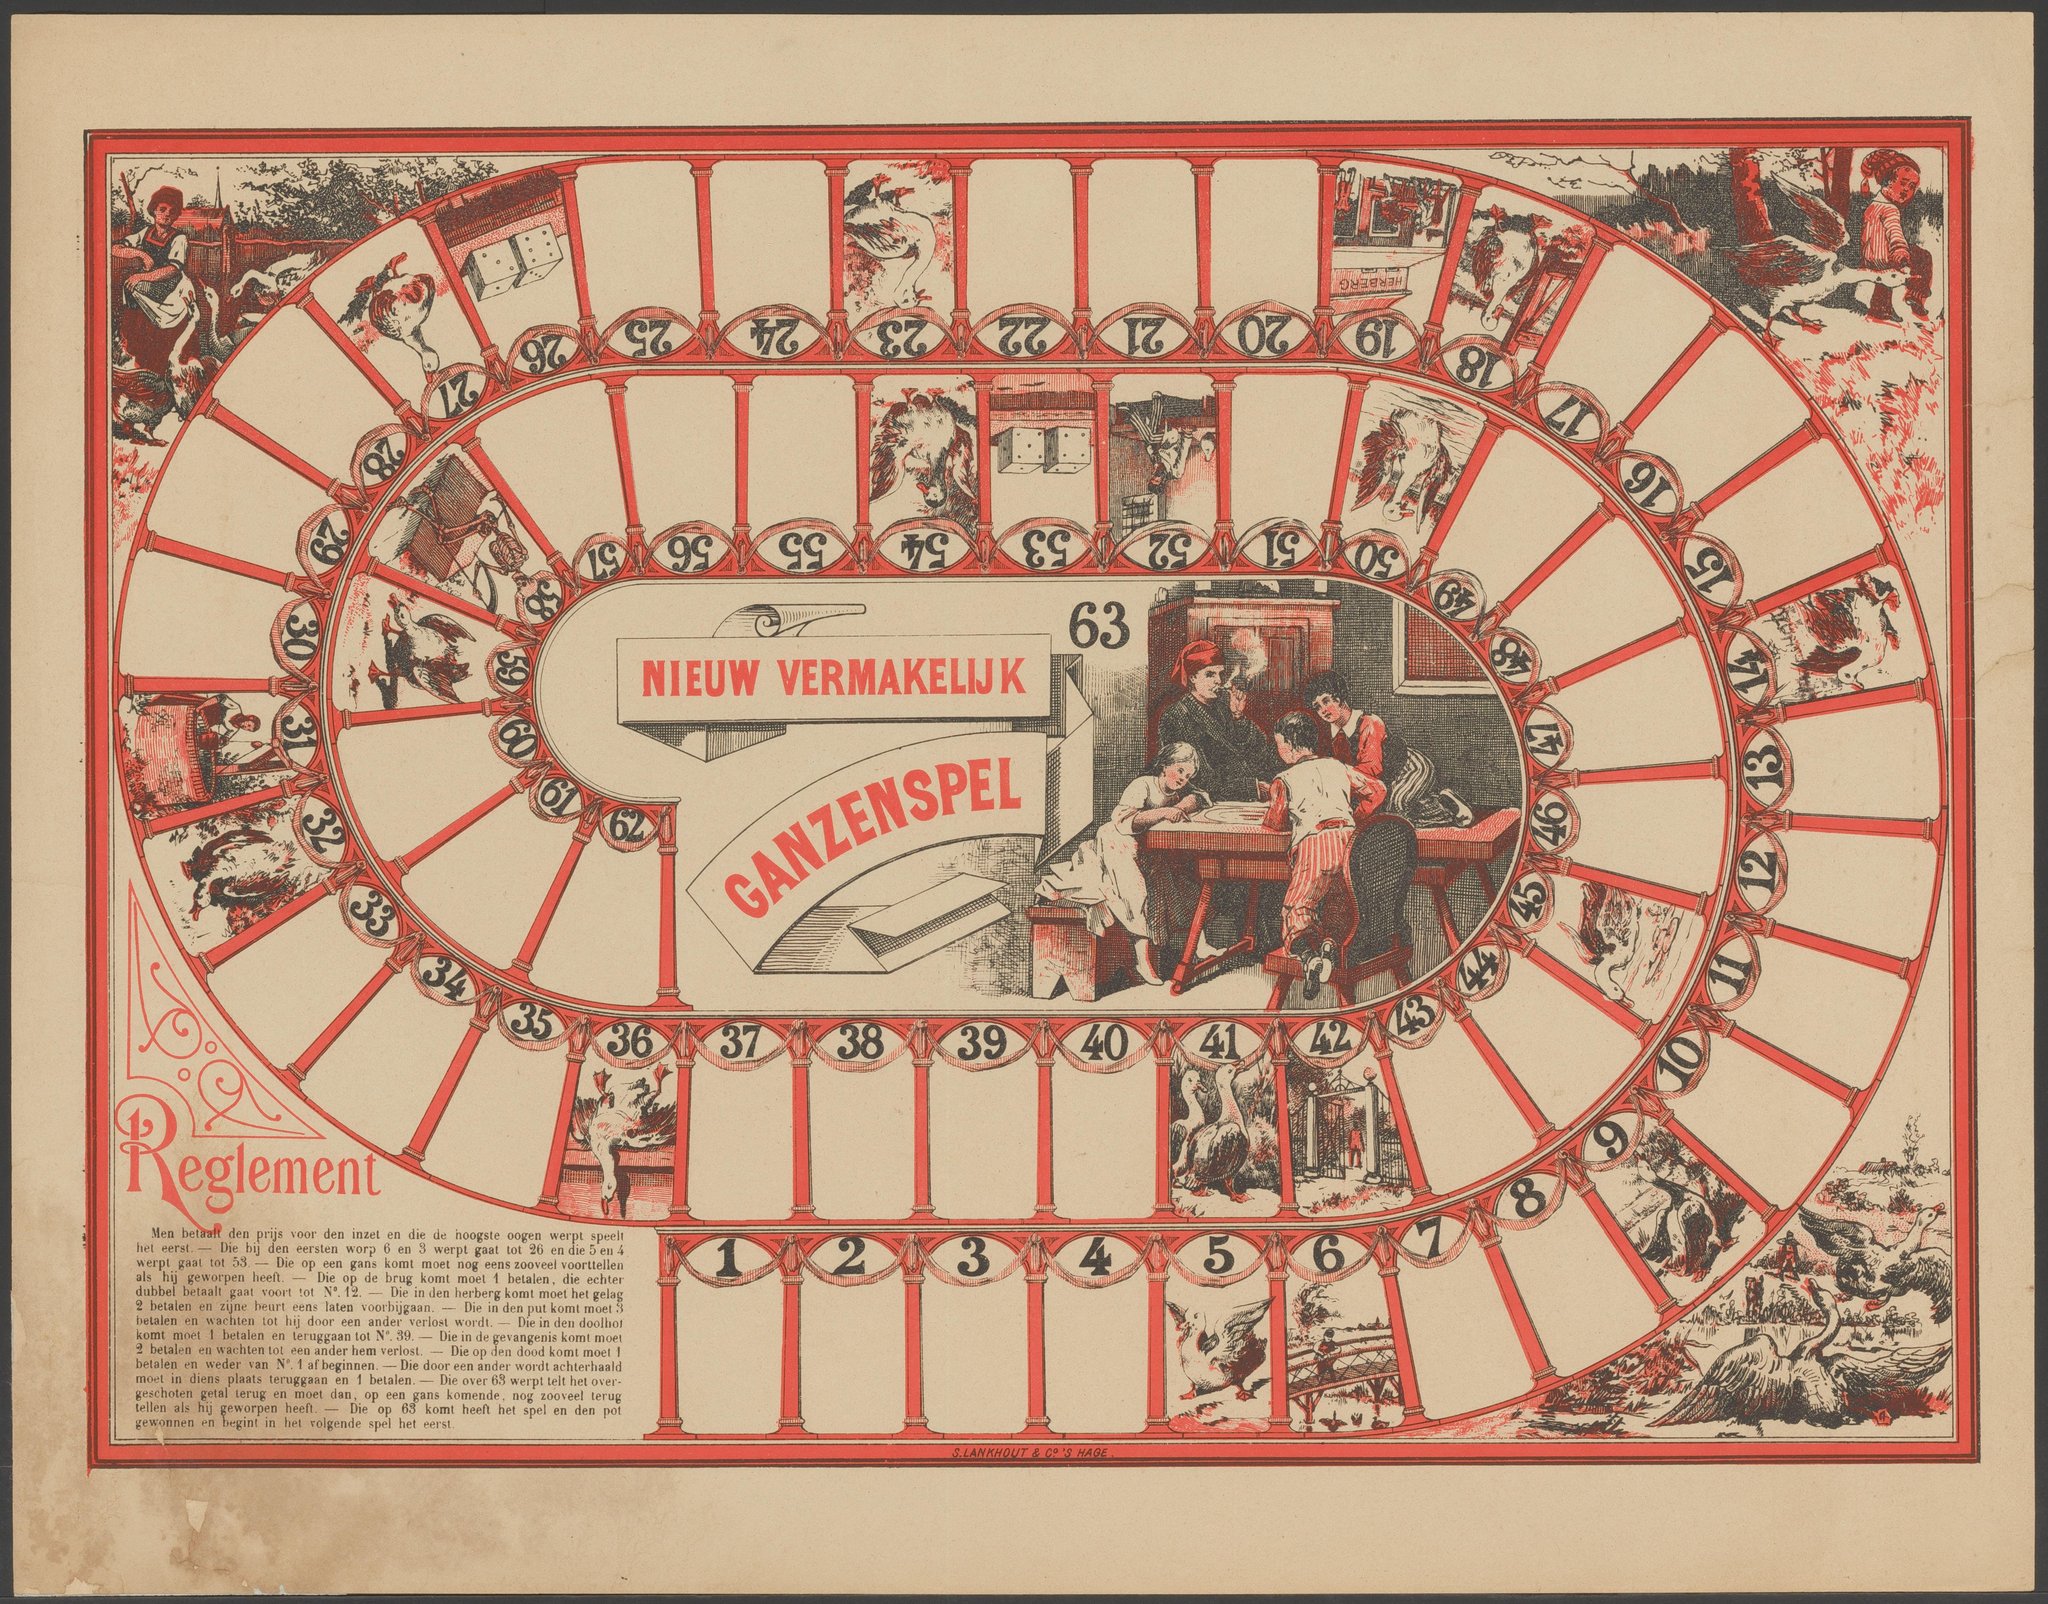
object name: print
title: Nieuw vermakelijk ganzenspel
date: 1870-1894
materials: paper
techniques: letterpress printing, lithograph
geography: the hague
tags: goose-game, board-games of chance, board-games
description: Ovaal ganzenbordspel met vakken in een spiraal van 1 tot 63. In het middenveld een afbeelding van een rokende man en drie kinderen die ganzenbord aan het spelen zijn. Een jongen zit boven op de tafel. Linksonder de spelregels. Rechtsonder een ganzenjacht. Linksboven een ganzenhoedster. Rechtsboven een jongen met een gans. Onderwerpsrubrieken binnen de Atlas Zeden en Gewoonten: Zeden en gewoonten in engeren zin, Spel en vermaak, Gezelschapsspel II, Ganzenbord en dergelijke.